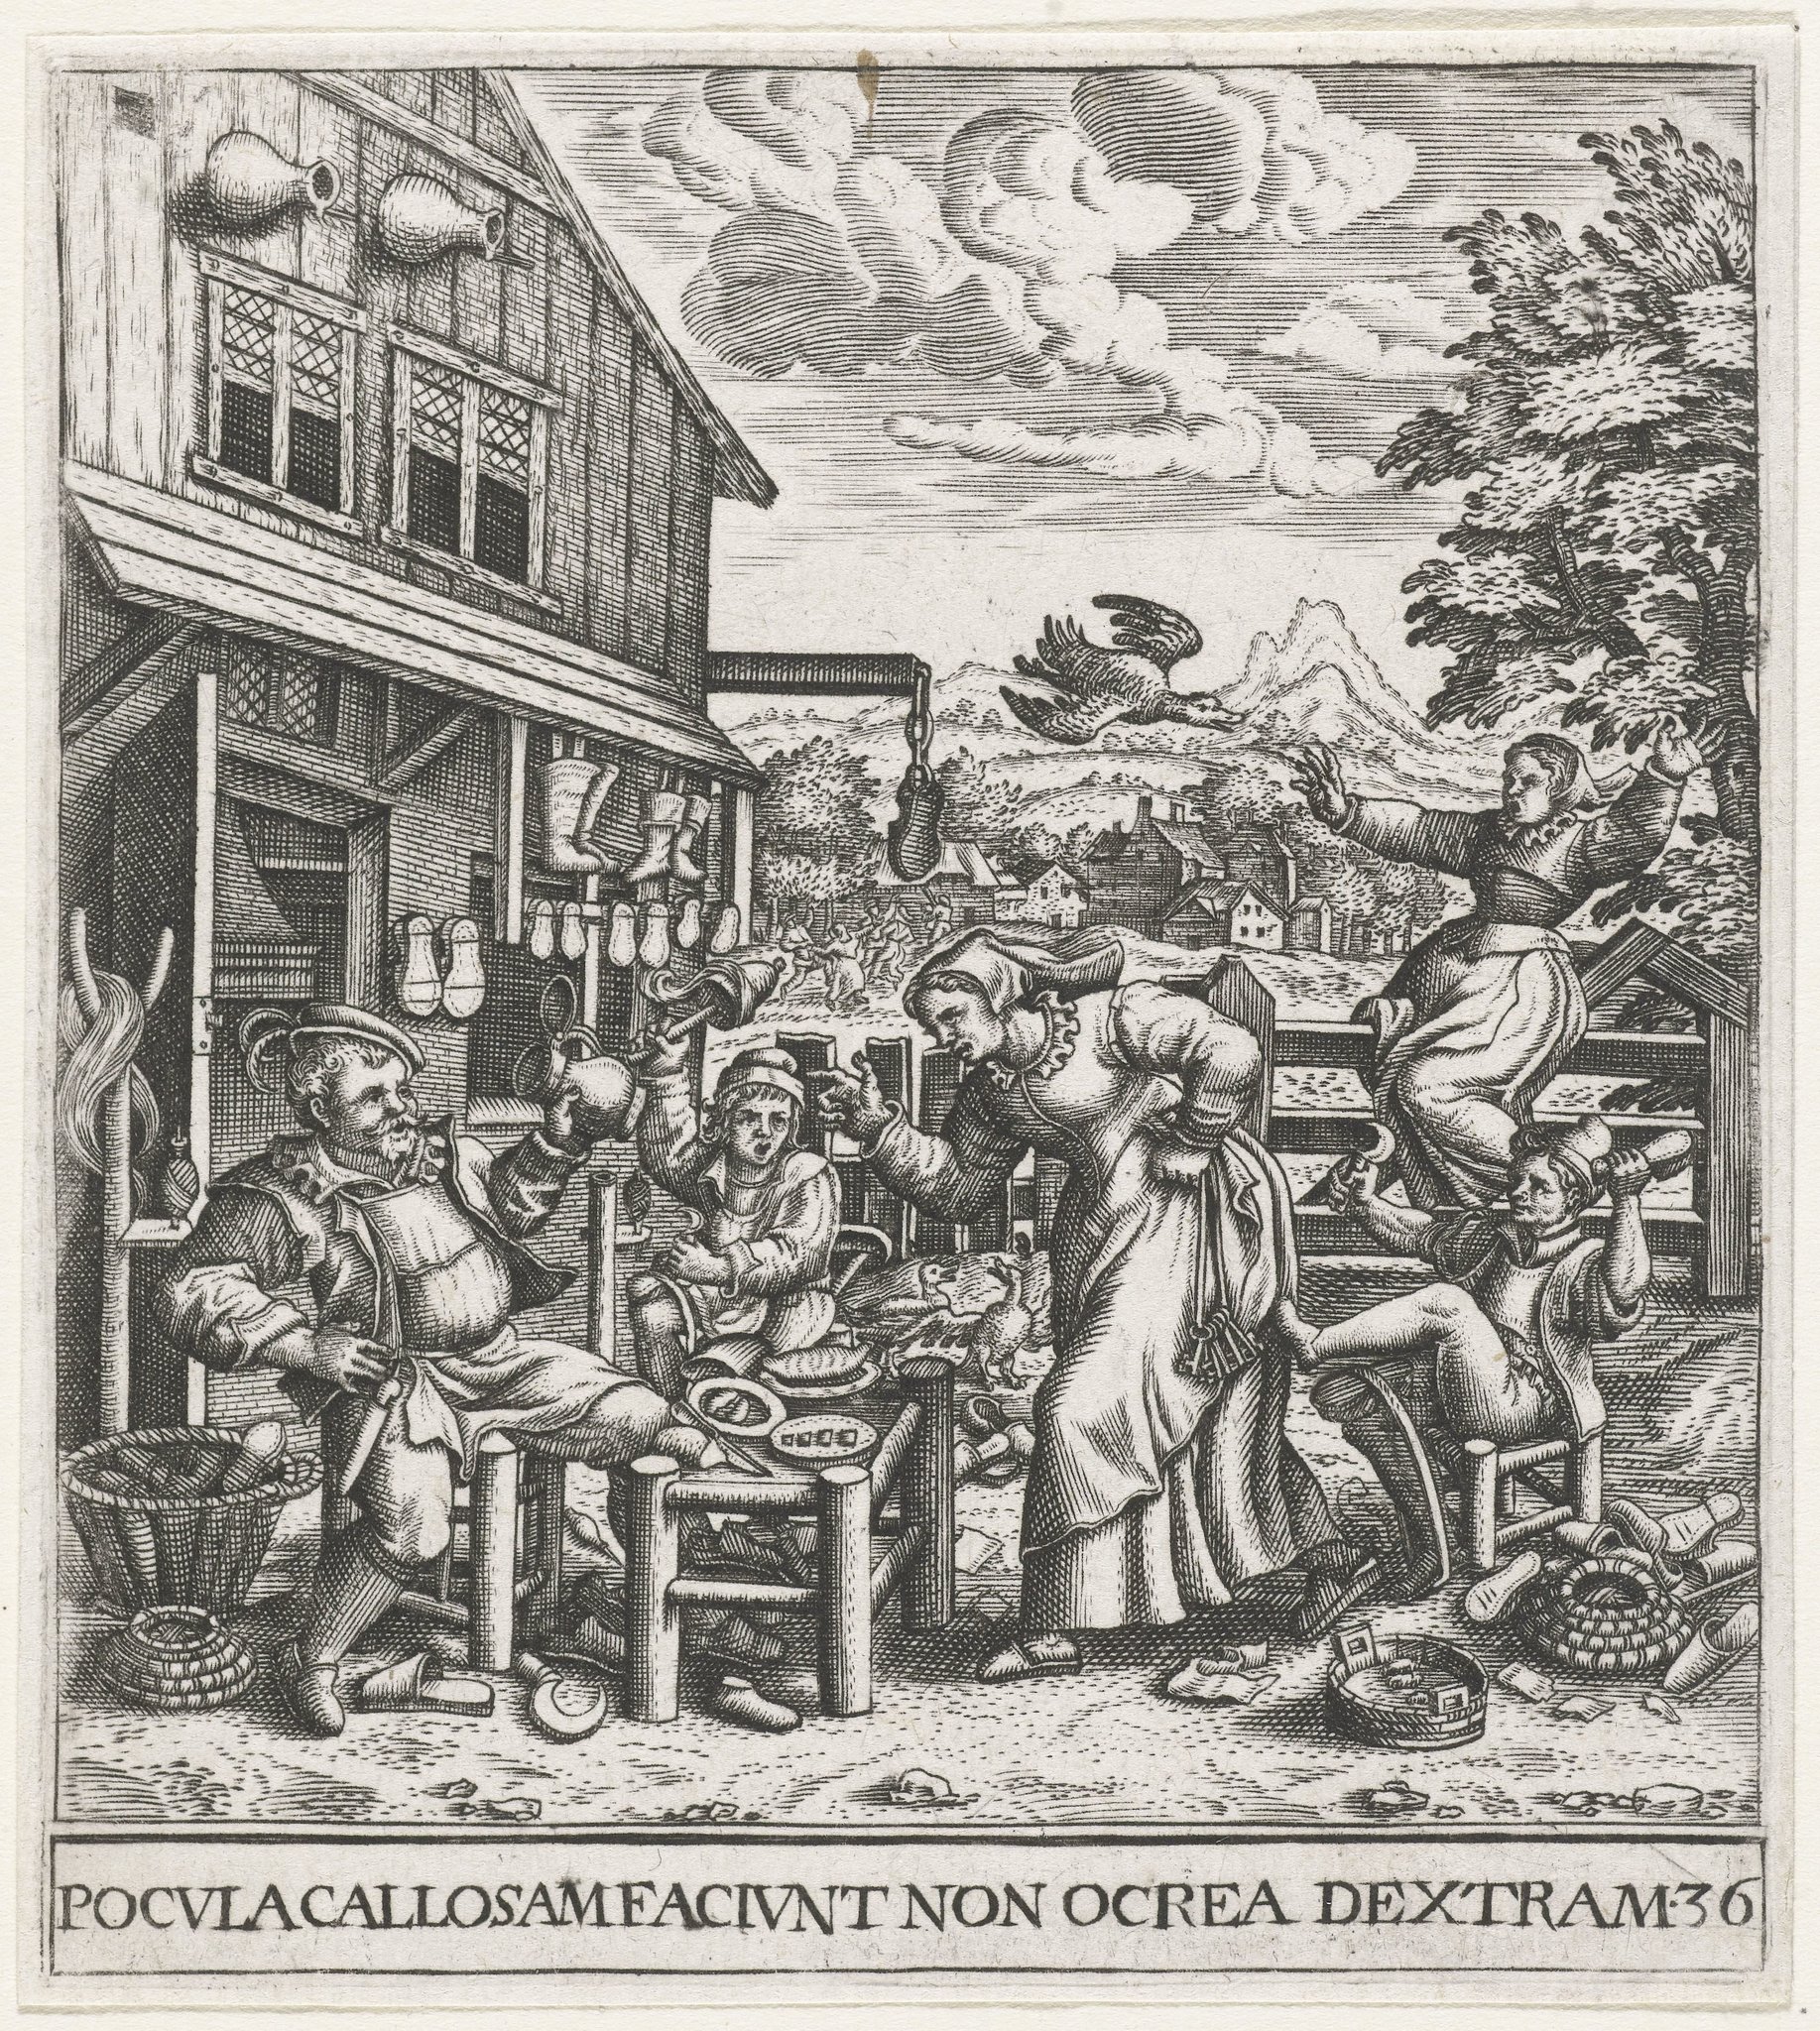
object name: print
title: De zorgeloze schoenmaker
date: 1596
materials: paper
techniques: engraving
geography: frankfurt am main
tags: existence and modes of existence (+ emblematical representation of concept), drunkenness, shoe-maker, cobbler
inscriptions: number: ‘36’, collector's mark: Lugt 240, inscription: ‘POCULA CALLOSAM FACIUNT NON OCREA DEXTRAM’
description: Waarschuwing tegen onverantwoordelijk en lichtzinnig gedrag. Een zorgeloze schoenmaker zit voor zijn huis en doet zich te goed doet aan een pint bier in plaats van zijn schoenen te lappen en zo voor inkomsten te zorgen. Zijn echtgenote gaat over zijn nalatigheid tegen hem te keer, maar daar schijnt hij zich niet veel van aan te trekken: Wa Vrouwe ghy kyft ons al te vroech ter quader ure/ Wij en sorghen maer/dat ons d'Bier inden pot nu niet en sure/ Schweycht doch/wy stellent al aen van tien en van viere/ Ich preyss ons Dochter op 't heck en die sorcht niet en fiere, lezen we in het epigram (bijbehorende tekst in album). Aan de gevel van het huis hangen twee bierpullen.